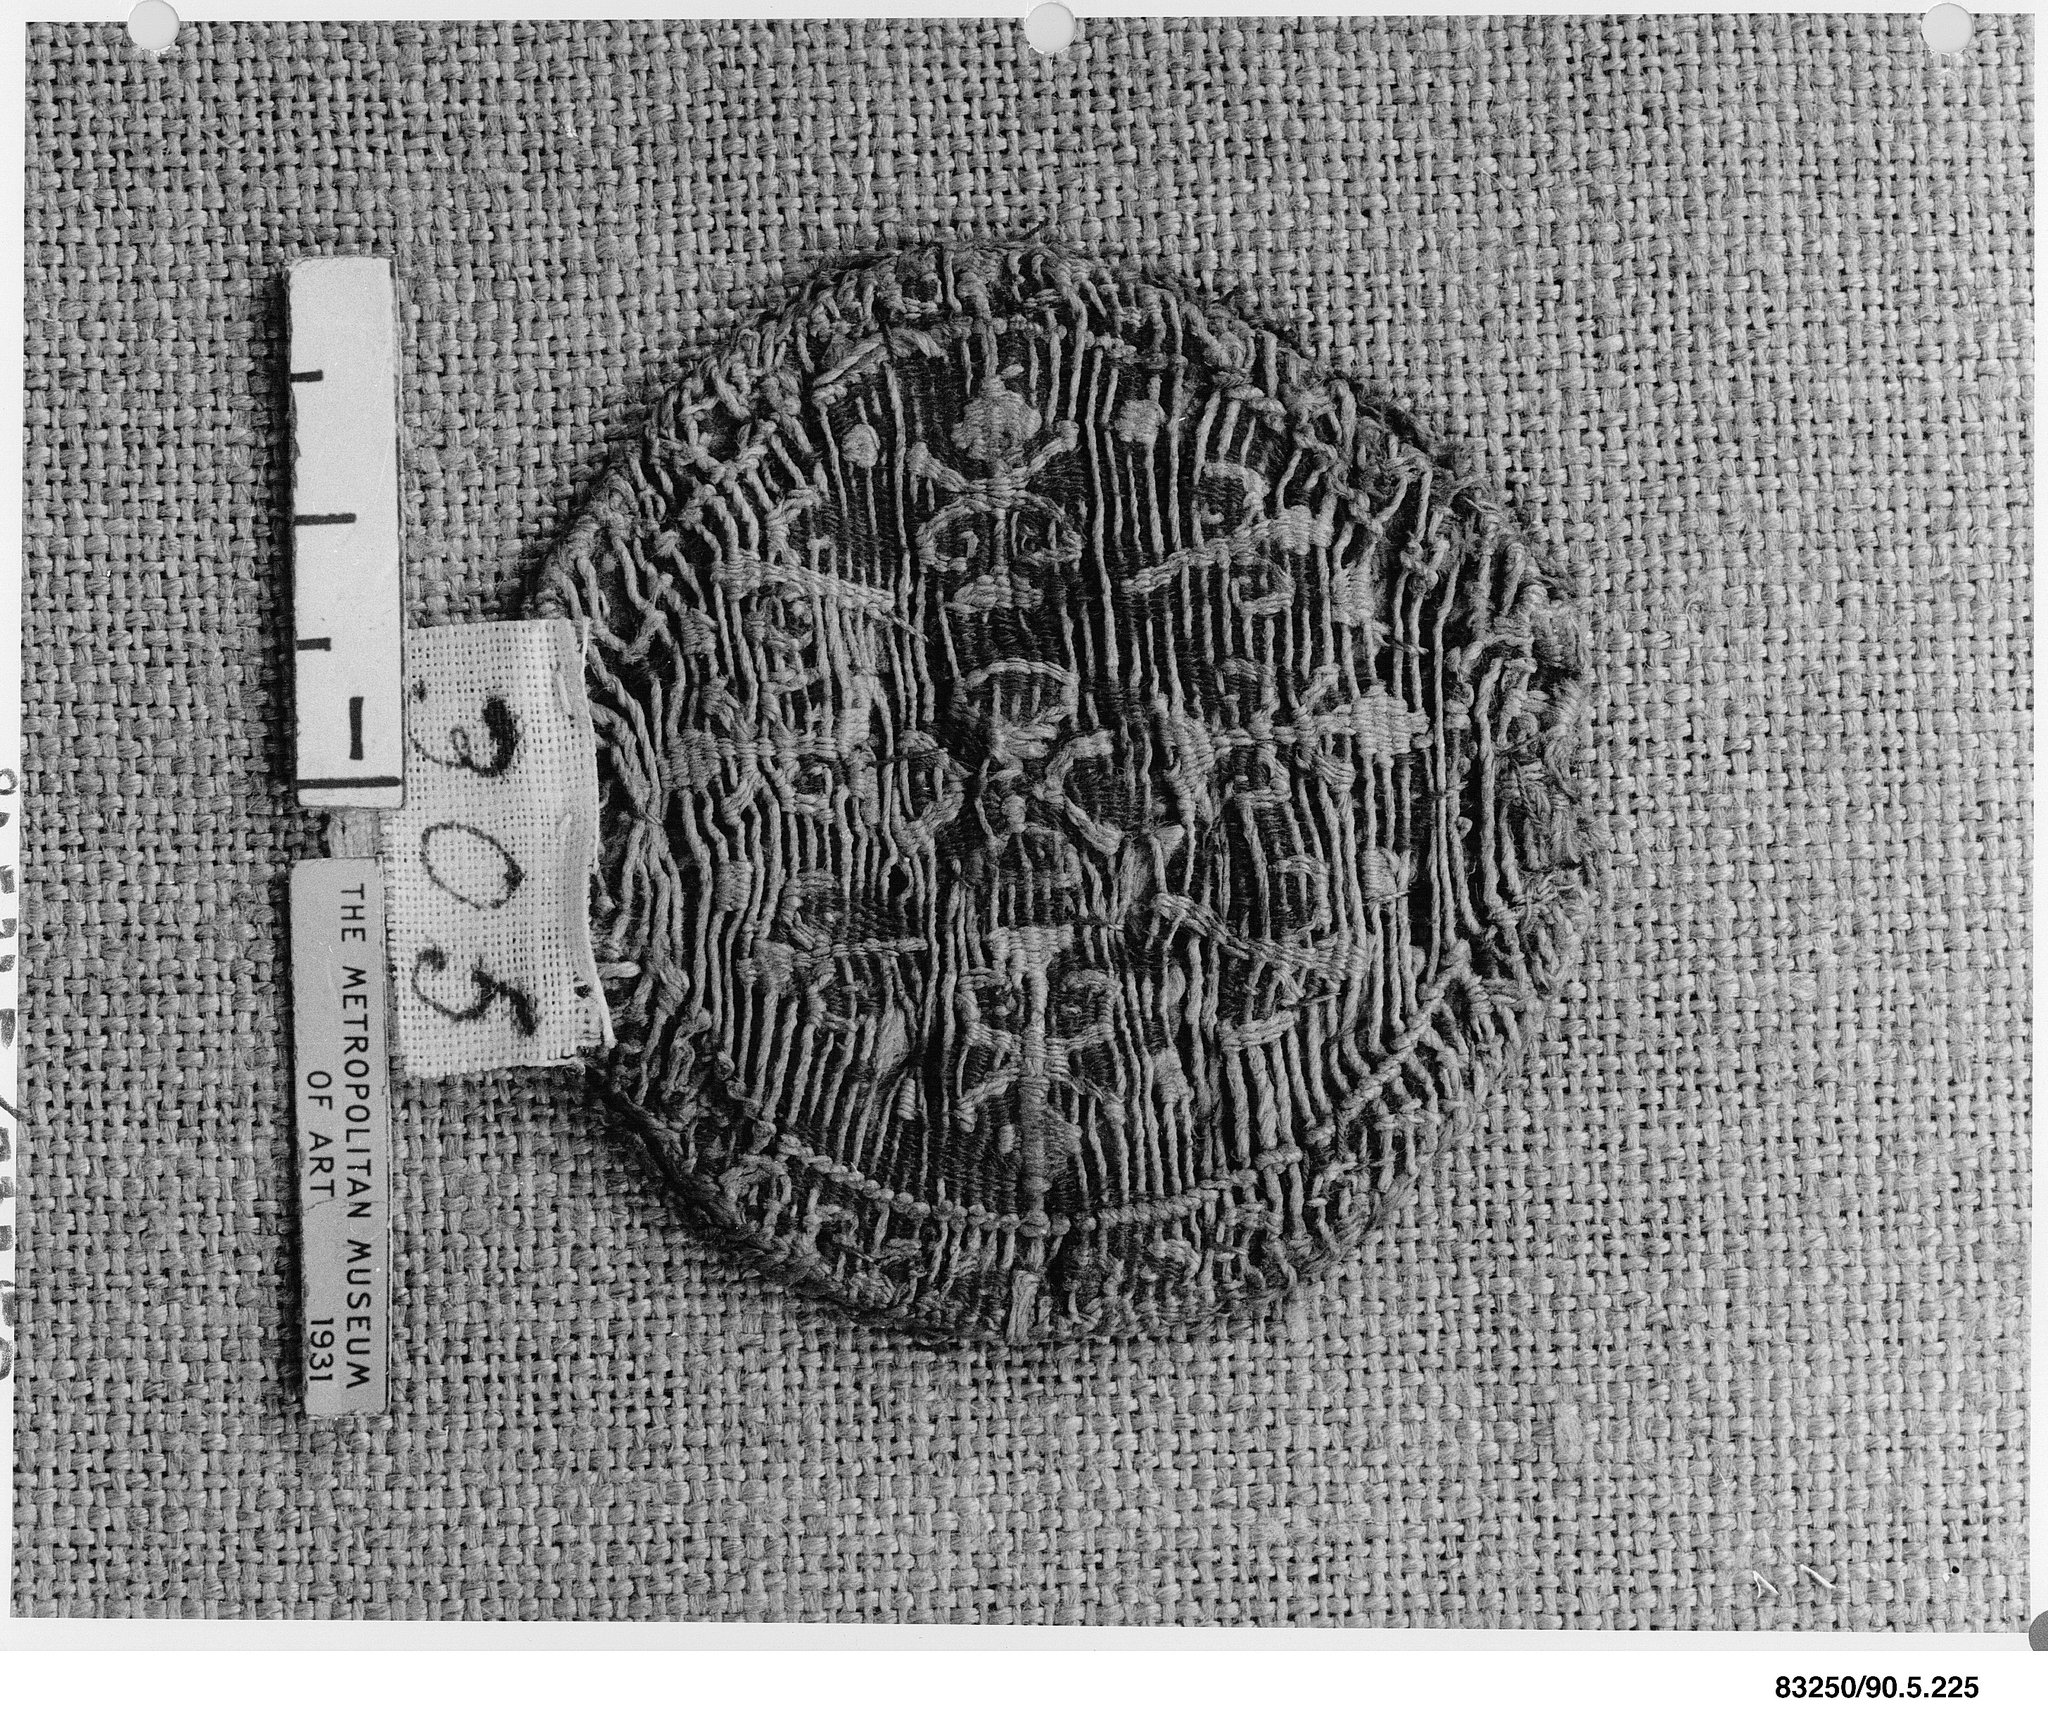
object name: textile fragment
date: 401-500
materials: linen, wool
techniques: weave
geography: egypt